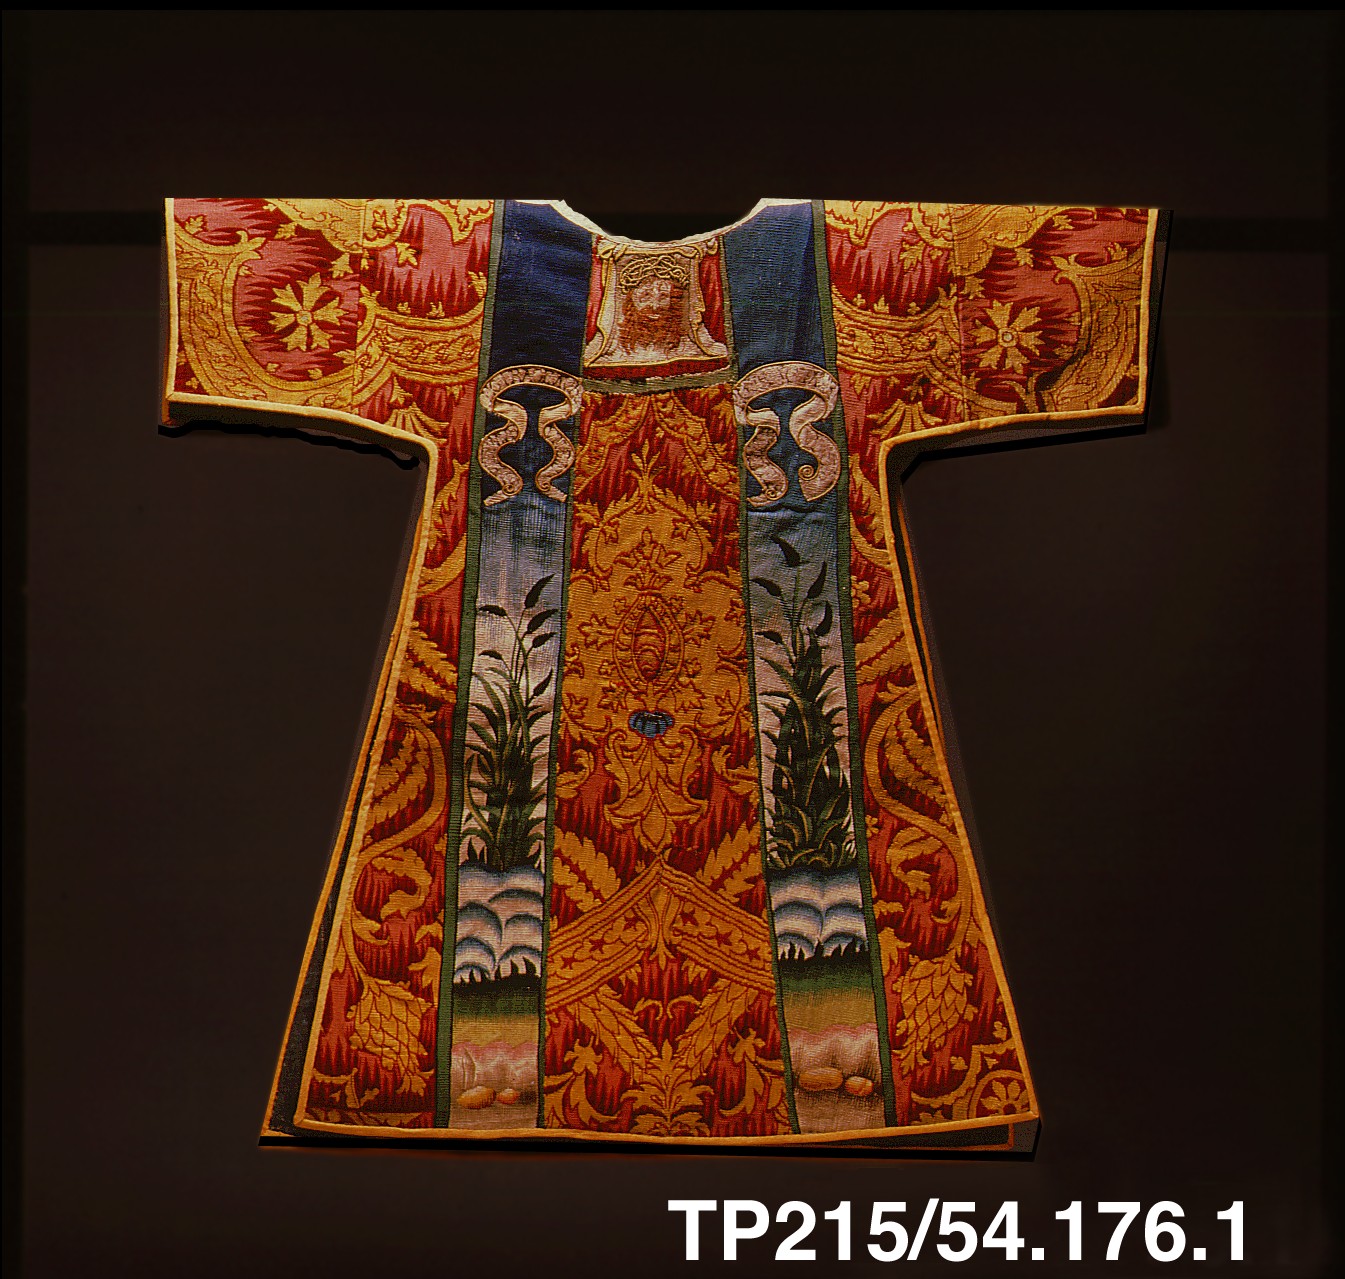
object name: vestment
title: Dalmatic with the Sudarium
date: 1570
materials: linen, silk, wool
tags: christ